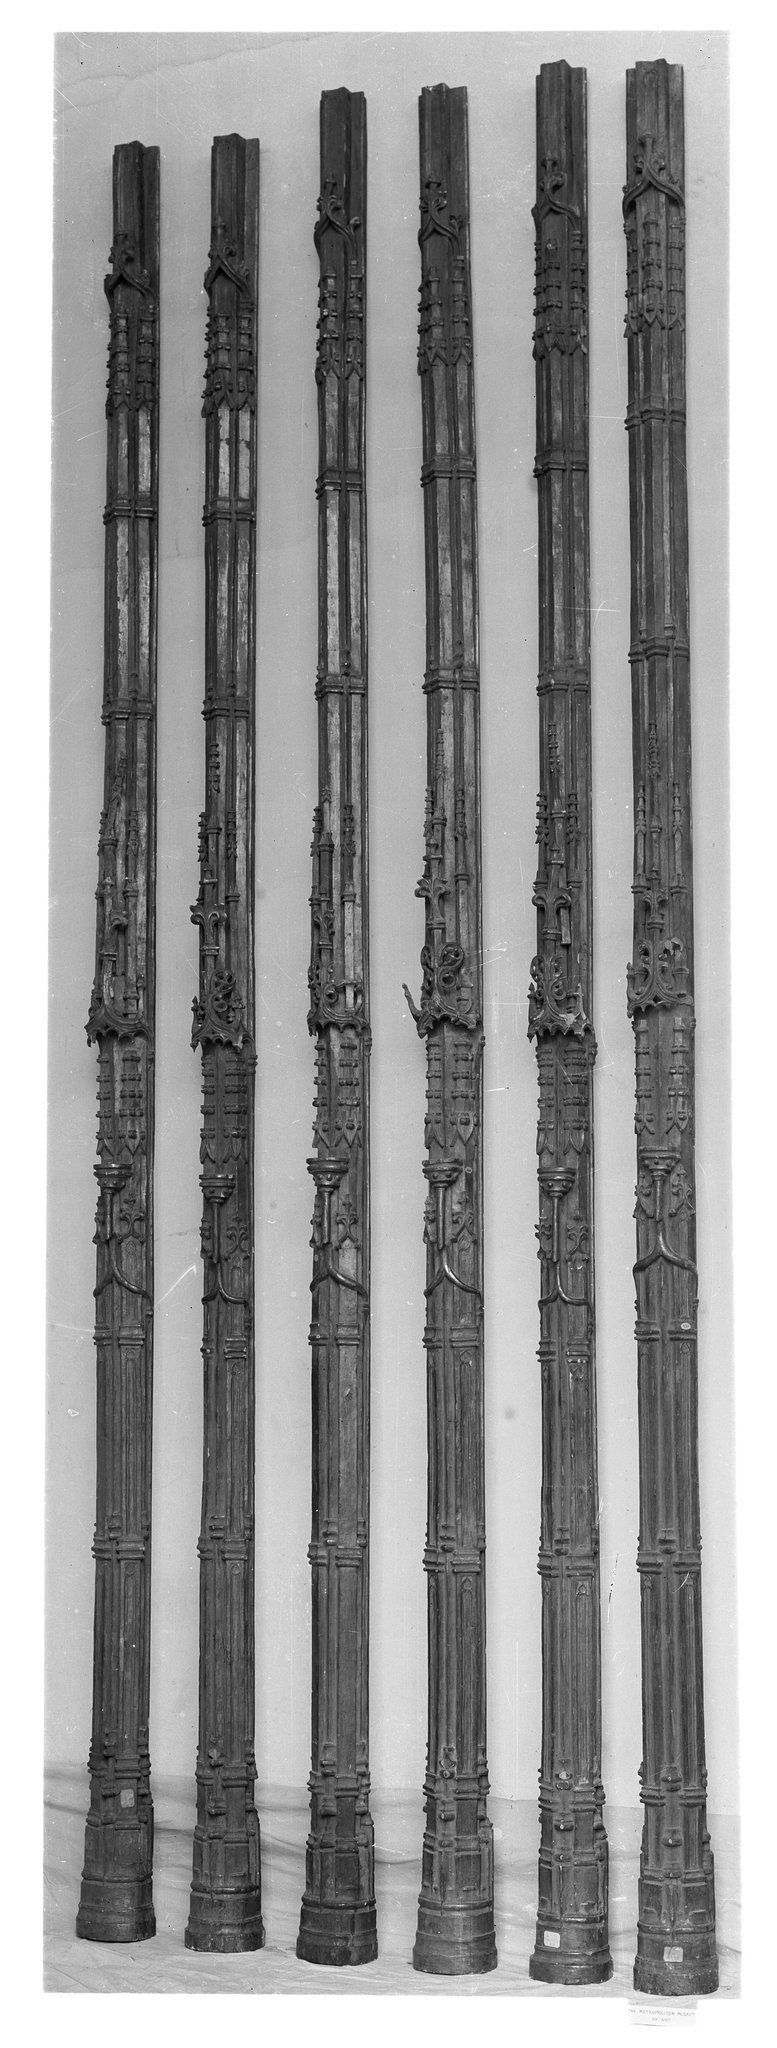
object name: pilaster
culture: french or italian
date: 1501-1600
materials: gold leaf, wood